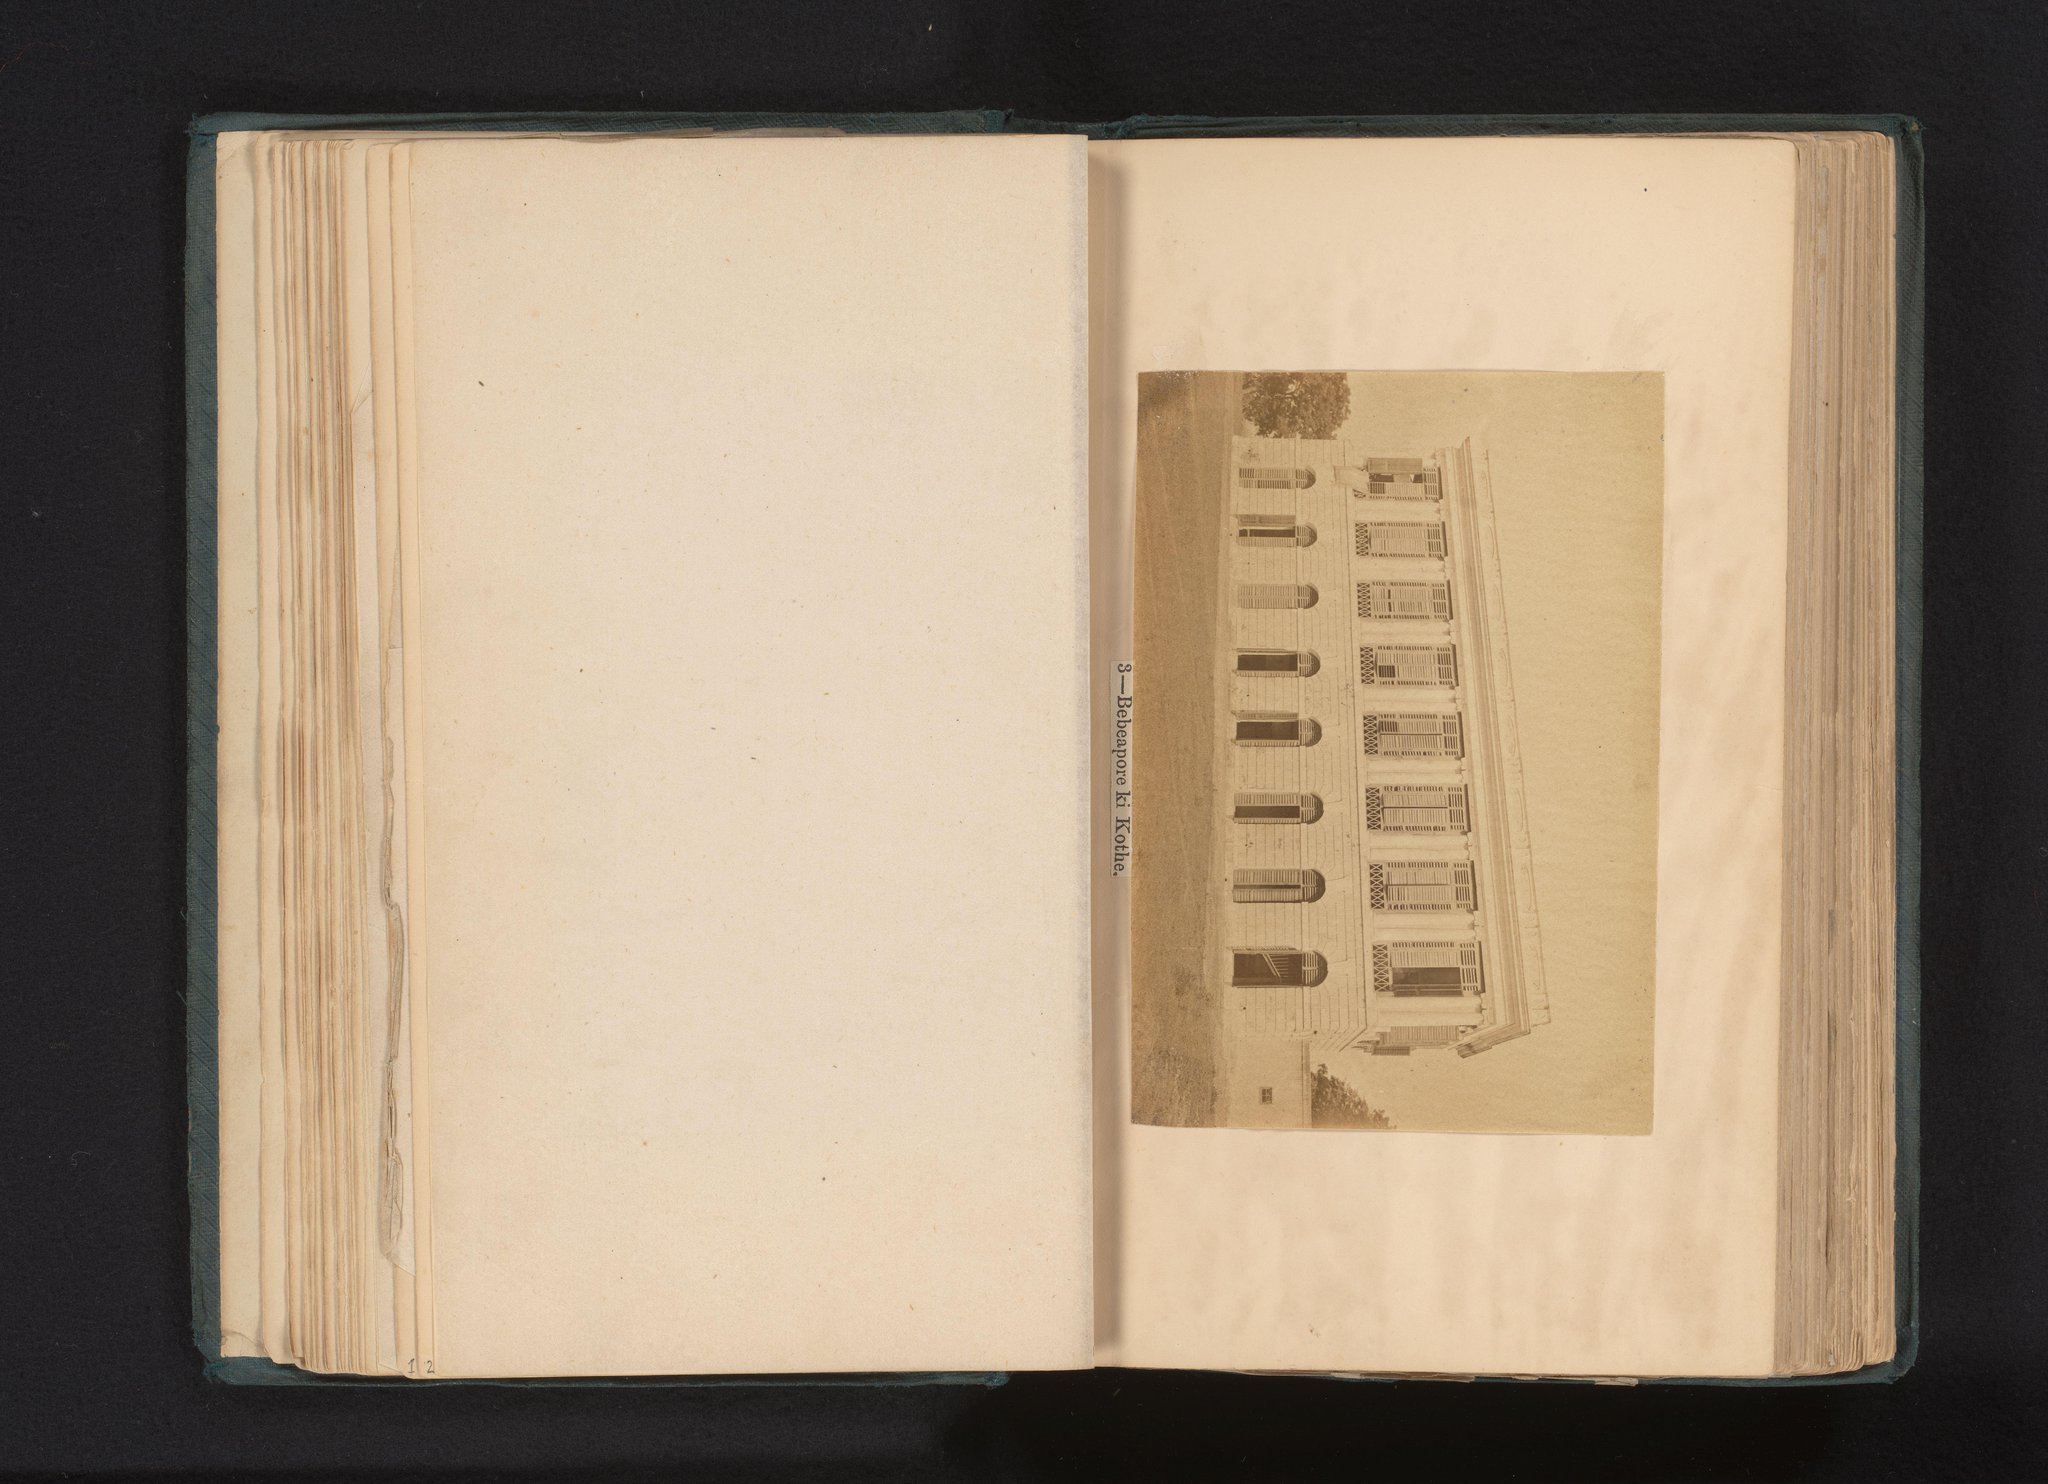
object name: photograph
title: Gezicht op het huis Bibiapur Kothi in Lucknow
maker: darogha ubbas alli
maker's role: fotograaf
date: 1862-1872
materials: photographic support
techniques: albumen print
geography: lucknow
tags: housing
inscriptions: number: ‘3’